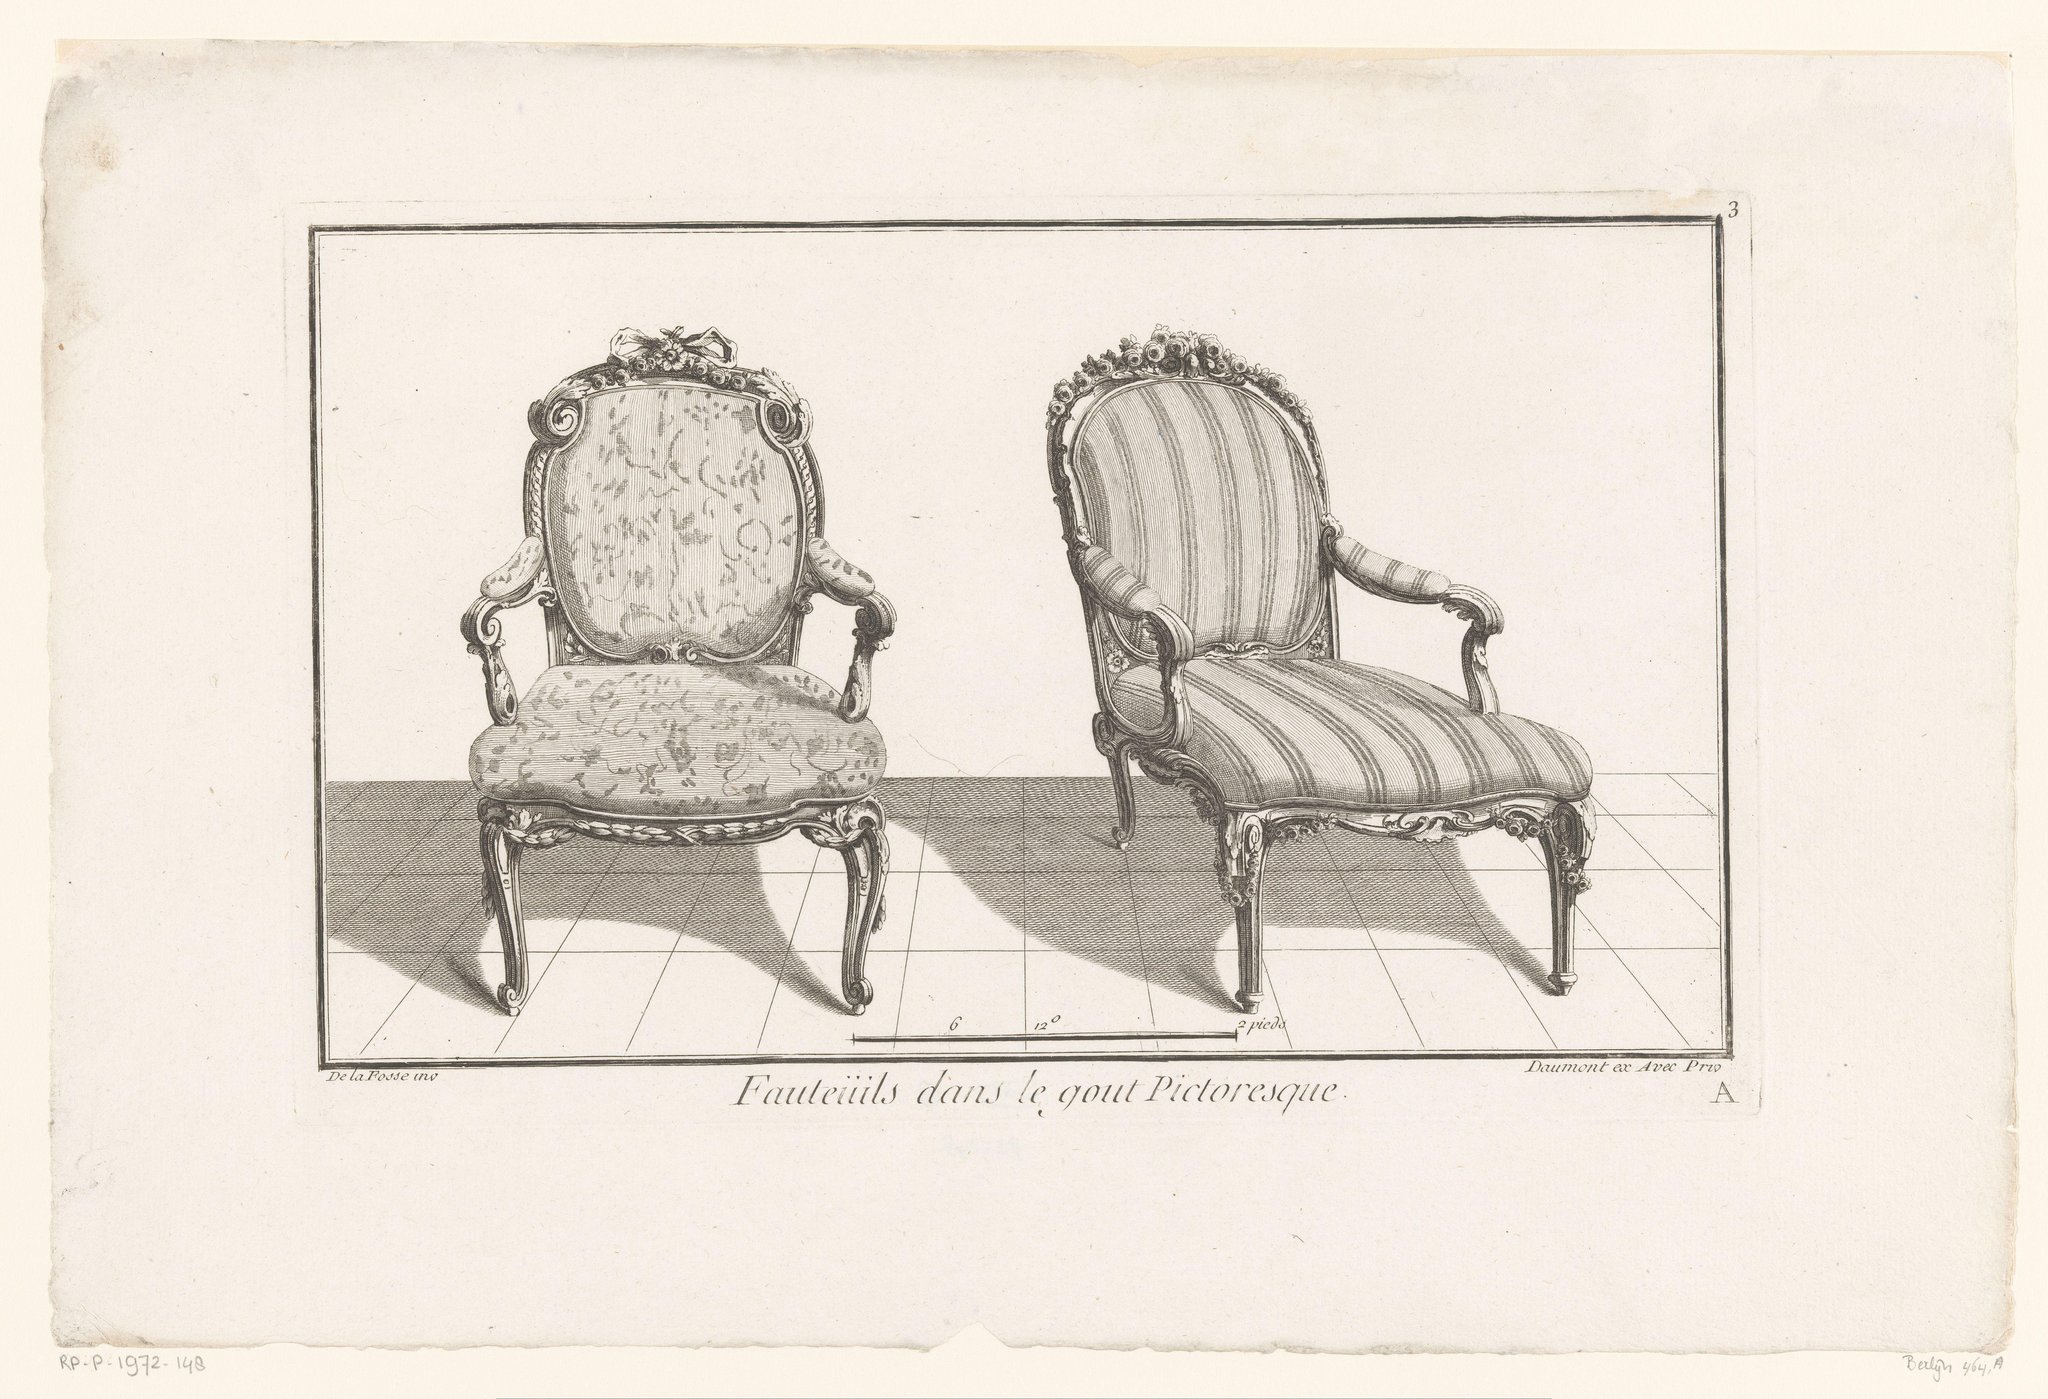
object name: print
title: Fauteüils dans le gout Pictoresque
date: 1745-1775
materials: paper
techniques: engraving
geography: paris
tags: chair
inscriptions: collector's mark: Lugt 2228, collector's mark: Lugt 2760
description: Links een stoel met bekleding met bloemen. Rechts een stoel met gestreepte bekleding.